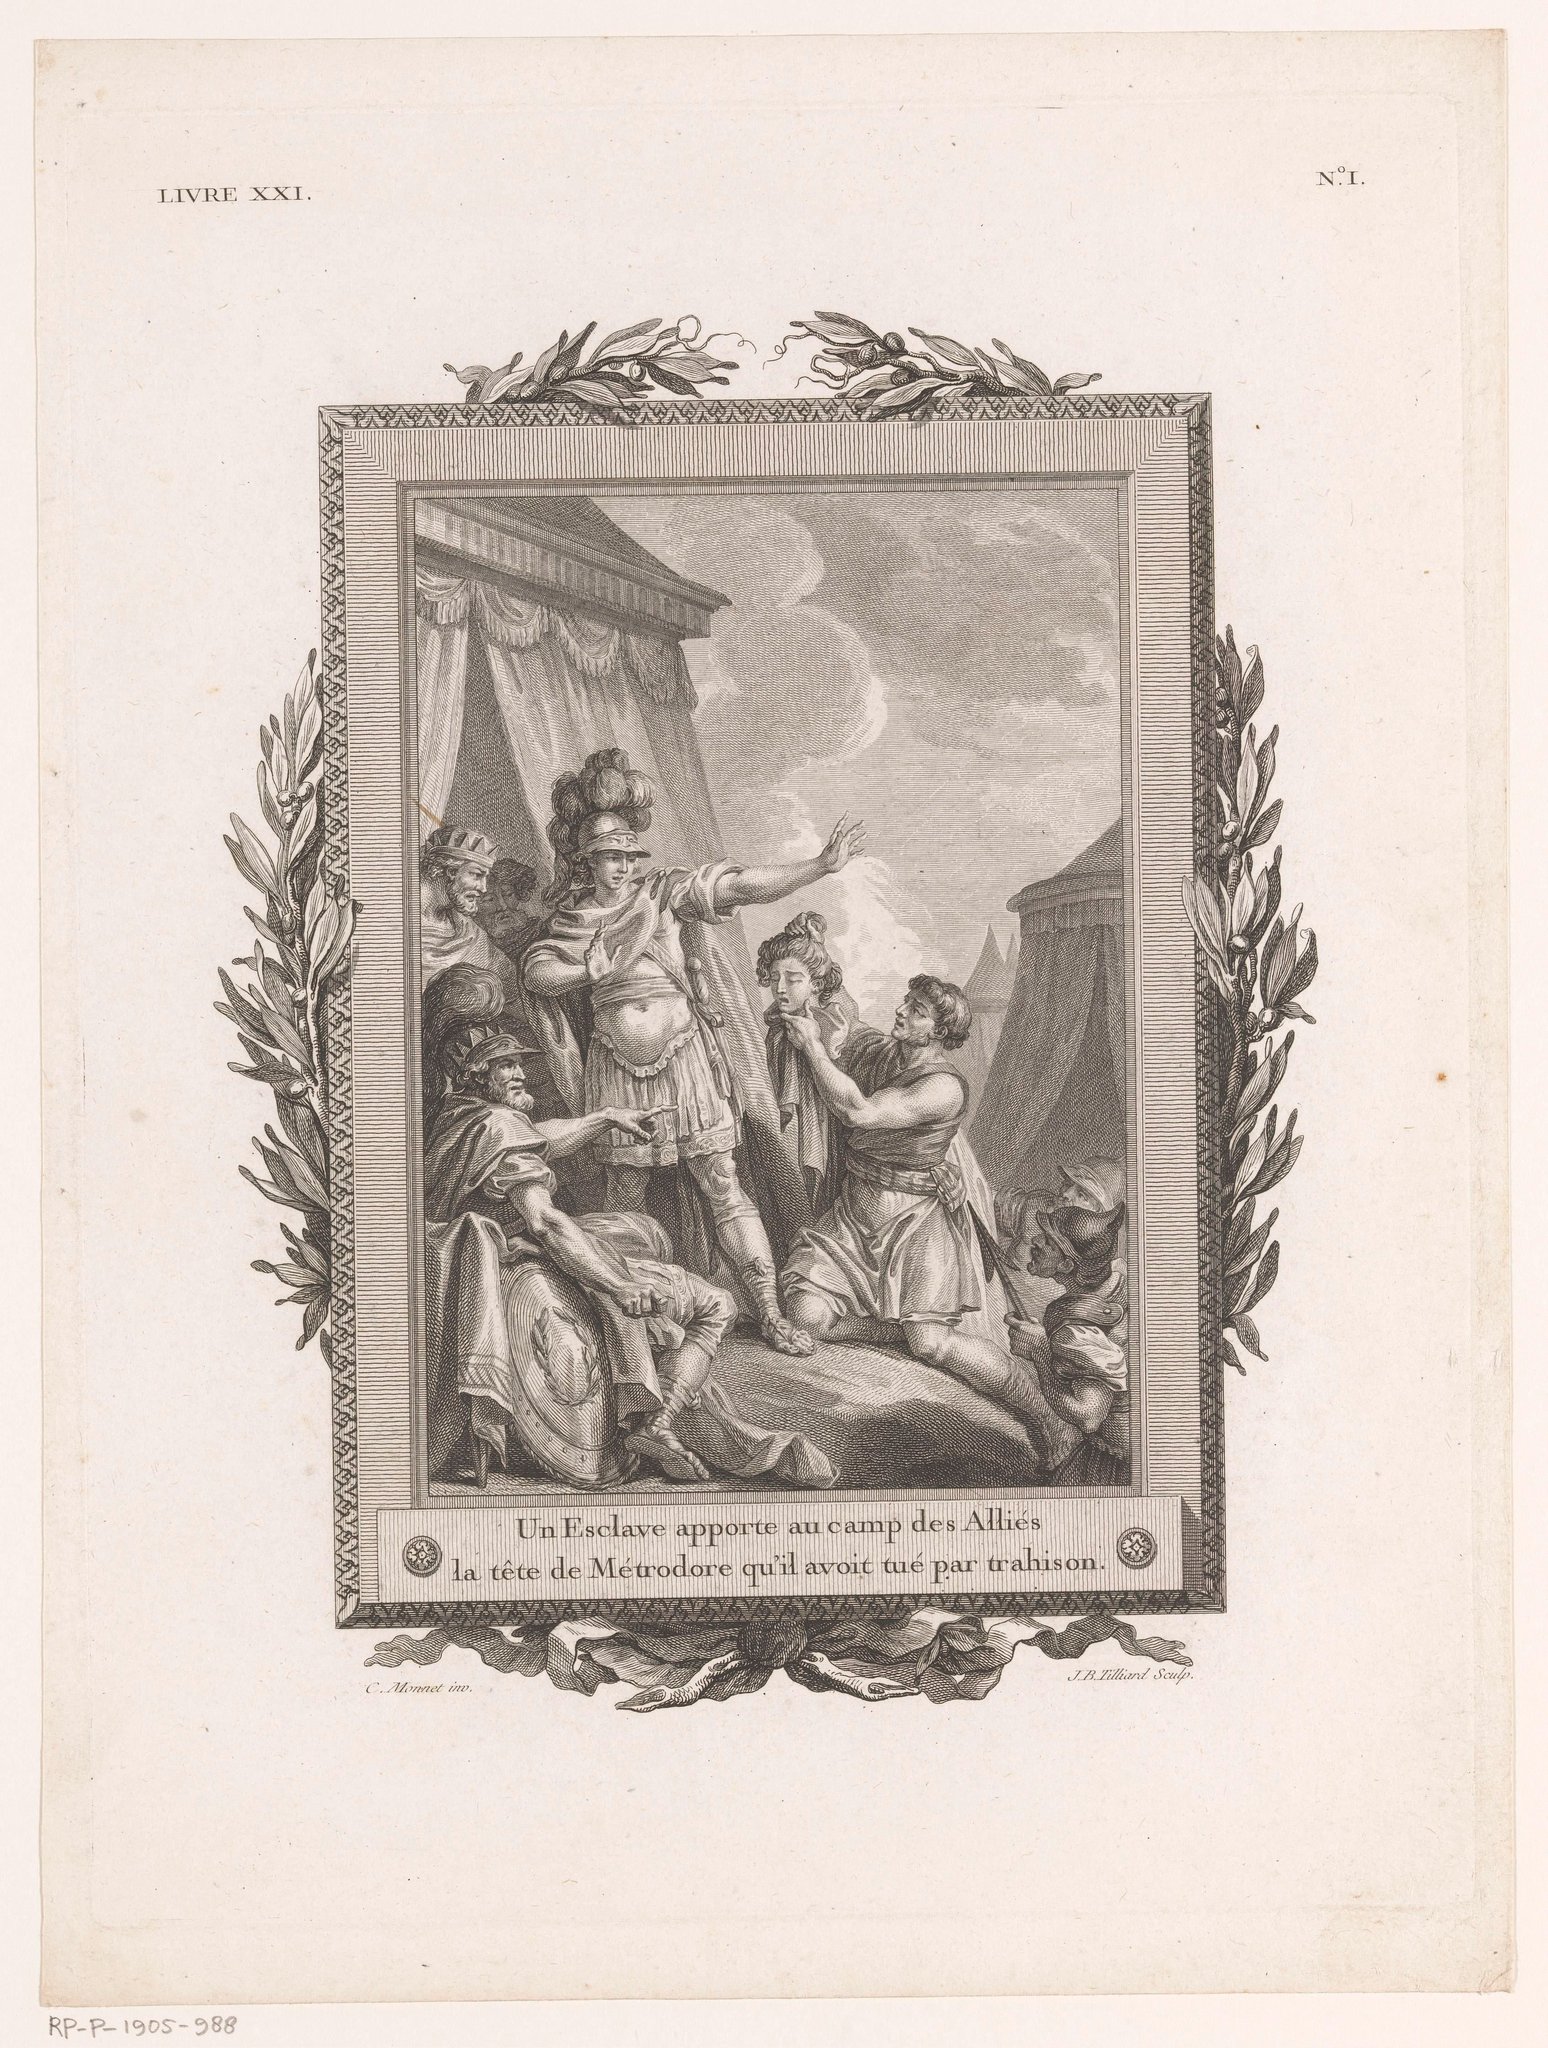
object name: print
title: Telemachus krijgt het hoofd van de verrader Metrodorus aangeboden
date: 1785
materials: paper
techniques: engraving, etching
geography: paris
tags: (fenelon, telemachus) specific works of literature (with author, title), (military) camp with tents, (story of) telemachus, ornament ~ festoon, garland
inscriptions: collector's mark: Lugt 2228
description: In een tentenkamp houdt een knielende bediende (rechts) het afgehakte hoofd van Metrodorus omhoog. Voor hem staat Telemachus voor een tent met opgeheven armen. Om hen heen bevinden zich soldaten en koningen. Het geheel wordt gekaderd door een sierlijst met olijftakken en onderaan een strik. Genummerd rechtsboven: No. I.